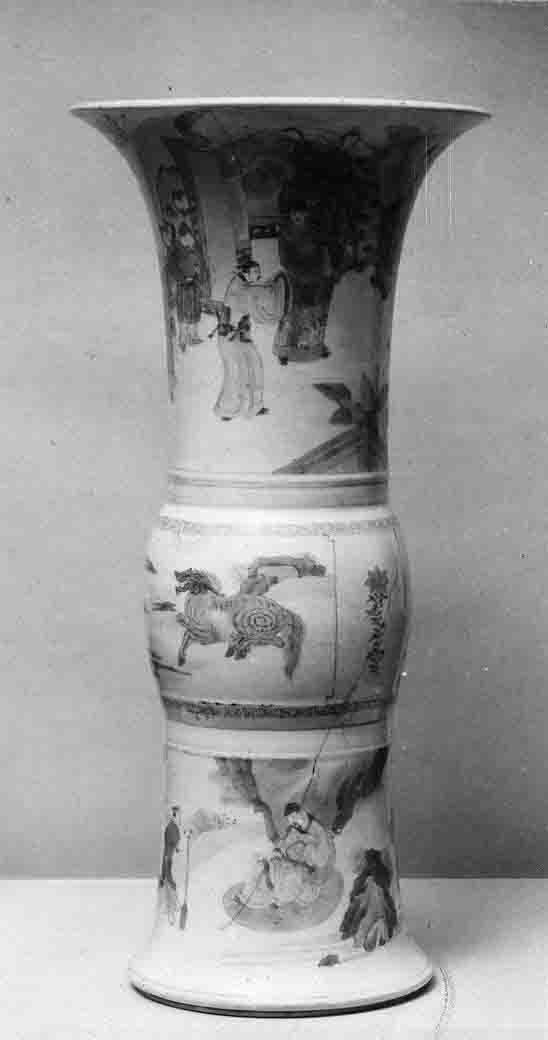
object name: vase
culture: chinese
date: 1662-1722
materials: porcelain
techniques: painting, underglaze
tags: animals,men